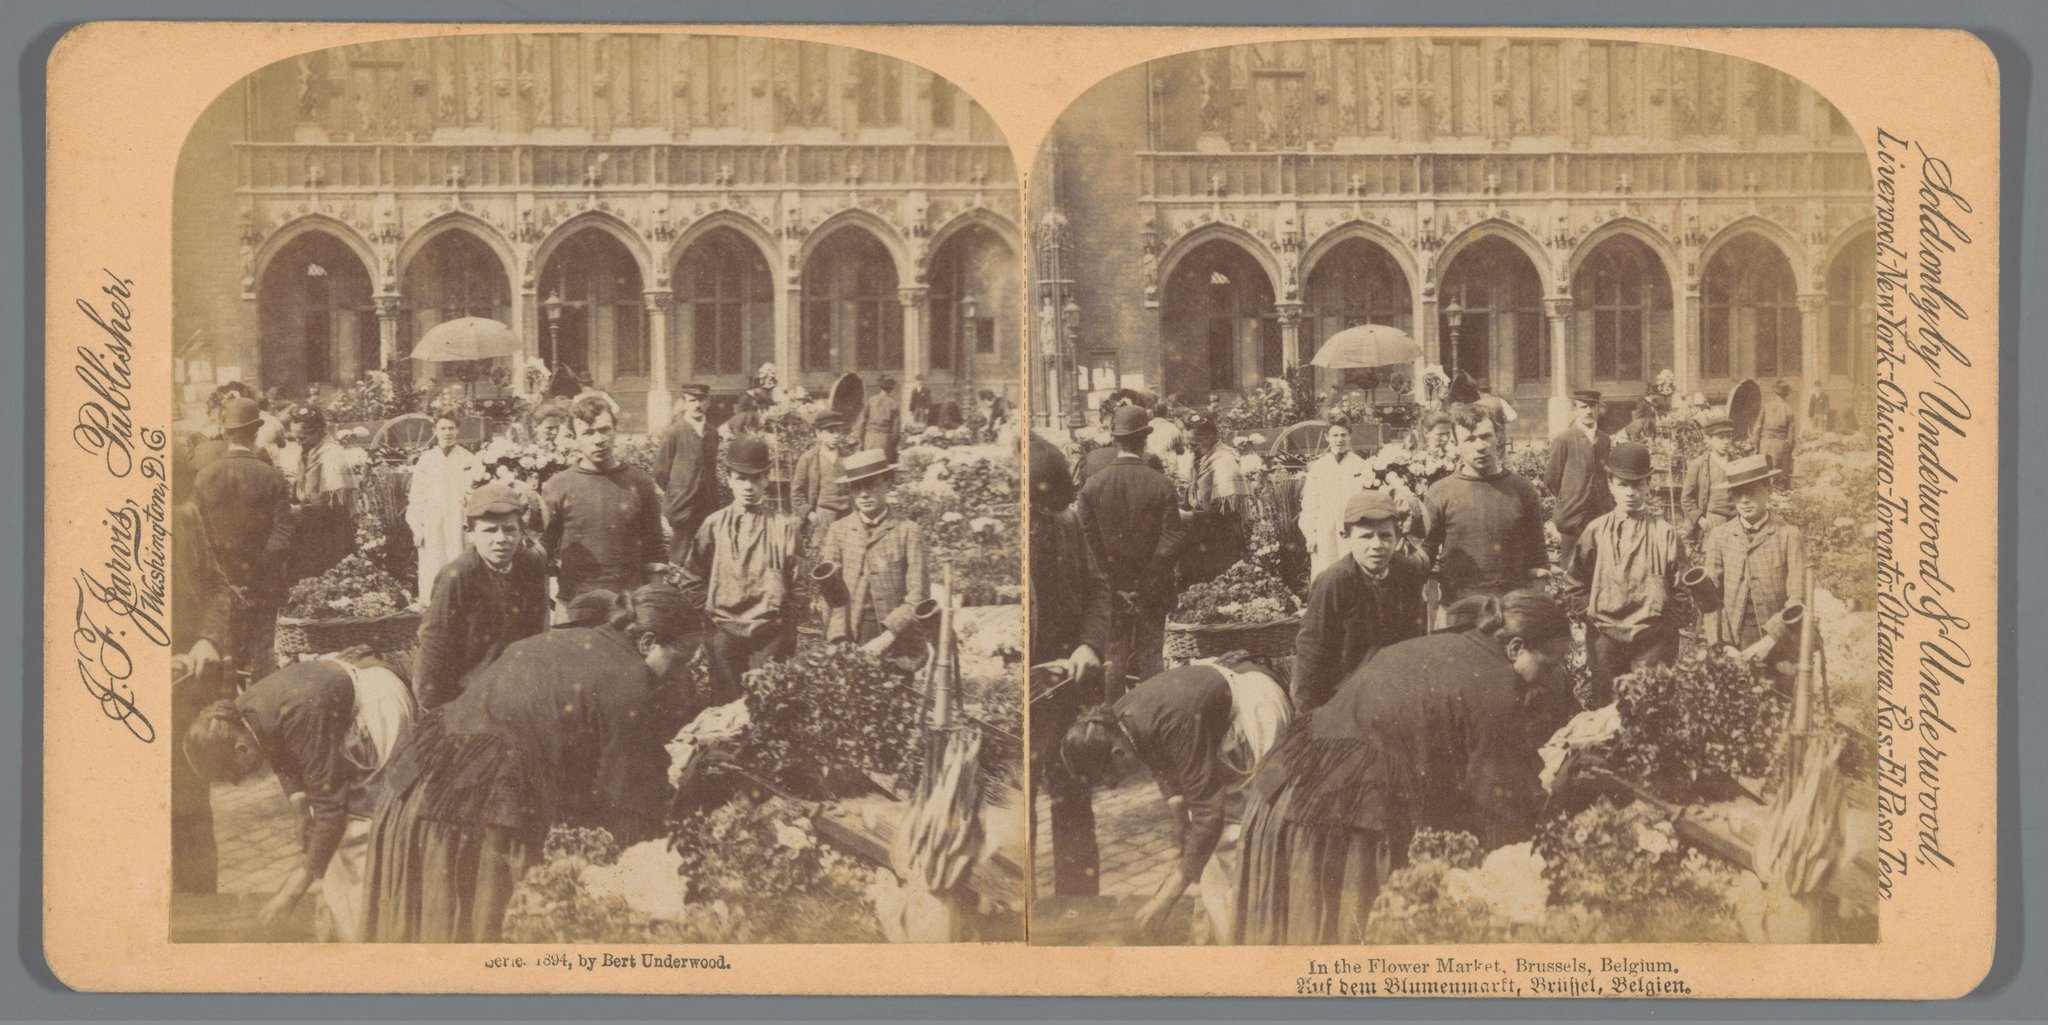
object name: stereograph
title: In the Flower Market, Brussels, Belgium. / Auf dem Blumenmarkt, Belgien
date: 1894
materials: cardboard, paper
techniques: albumen print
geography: brussels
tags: market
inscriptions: inscription: ‘3.’, inscription: ‘Sold only by Underwood & Underwood/ Liverpool,- New York,- Chicago,- Toronto,- Ottawa,- Kas,- El Paso Tex.’